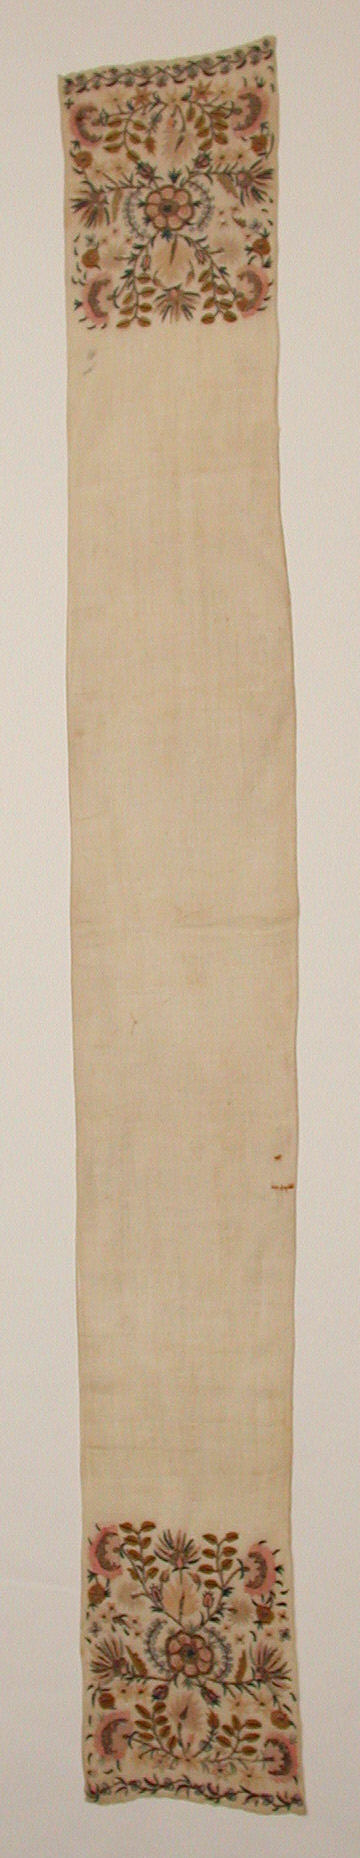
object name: scarf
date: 1701-1800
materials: cotton, metal thread, silk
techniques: embroidery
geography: turkey